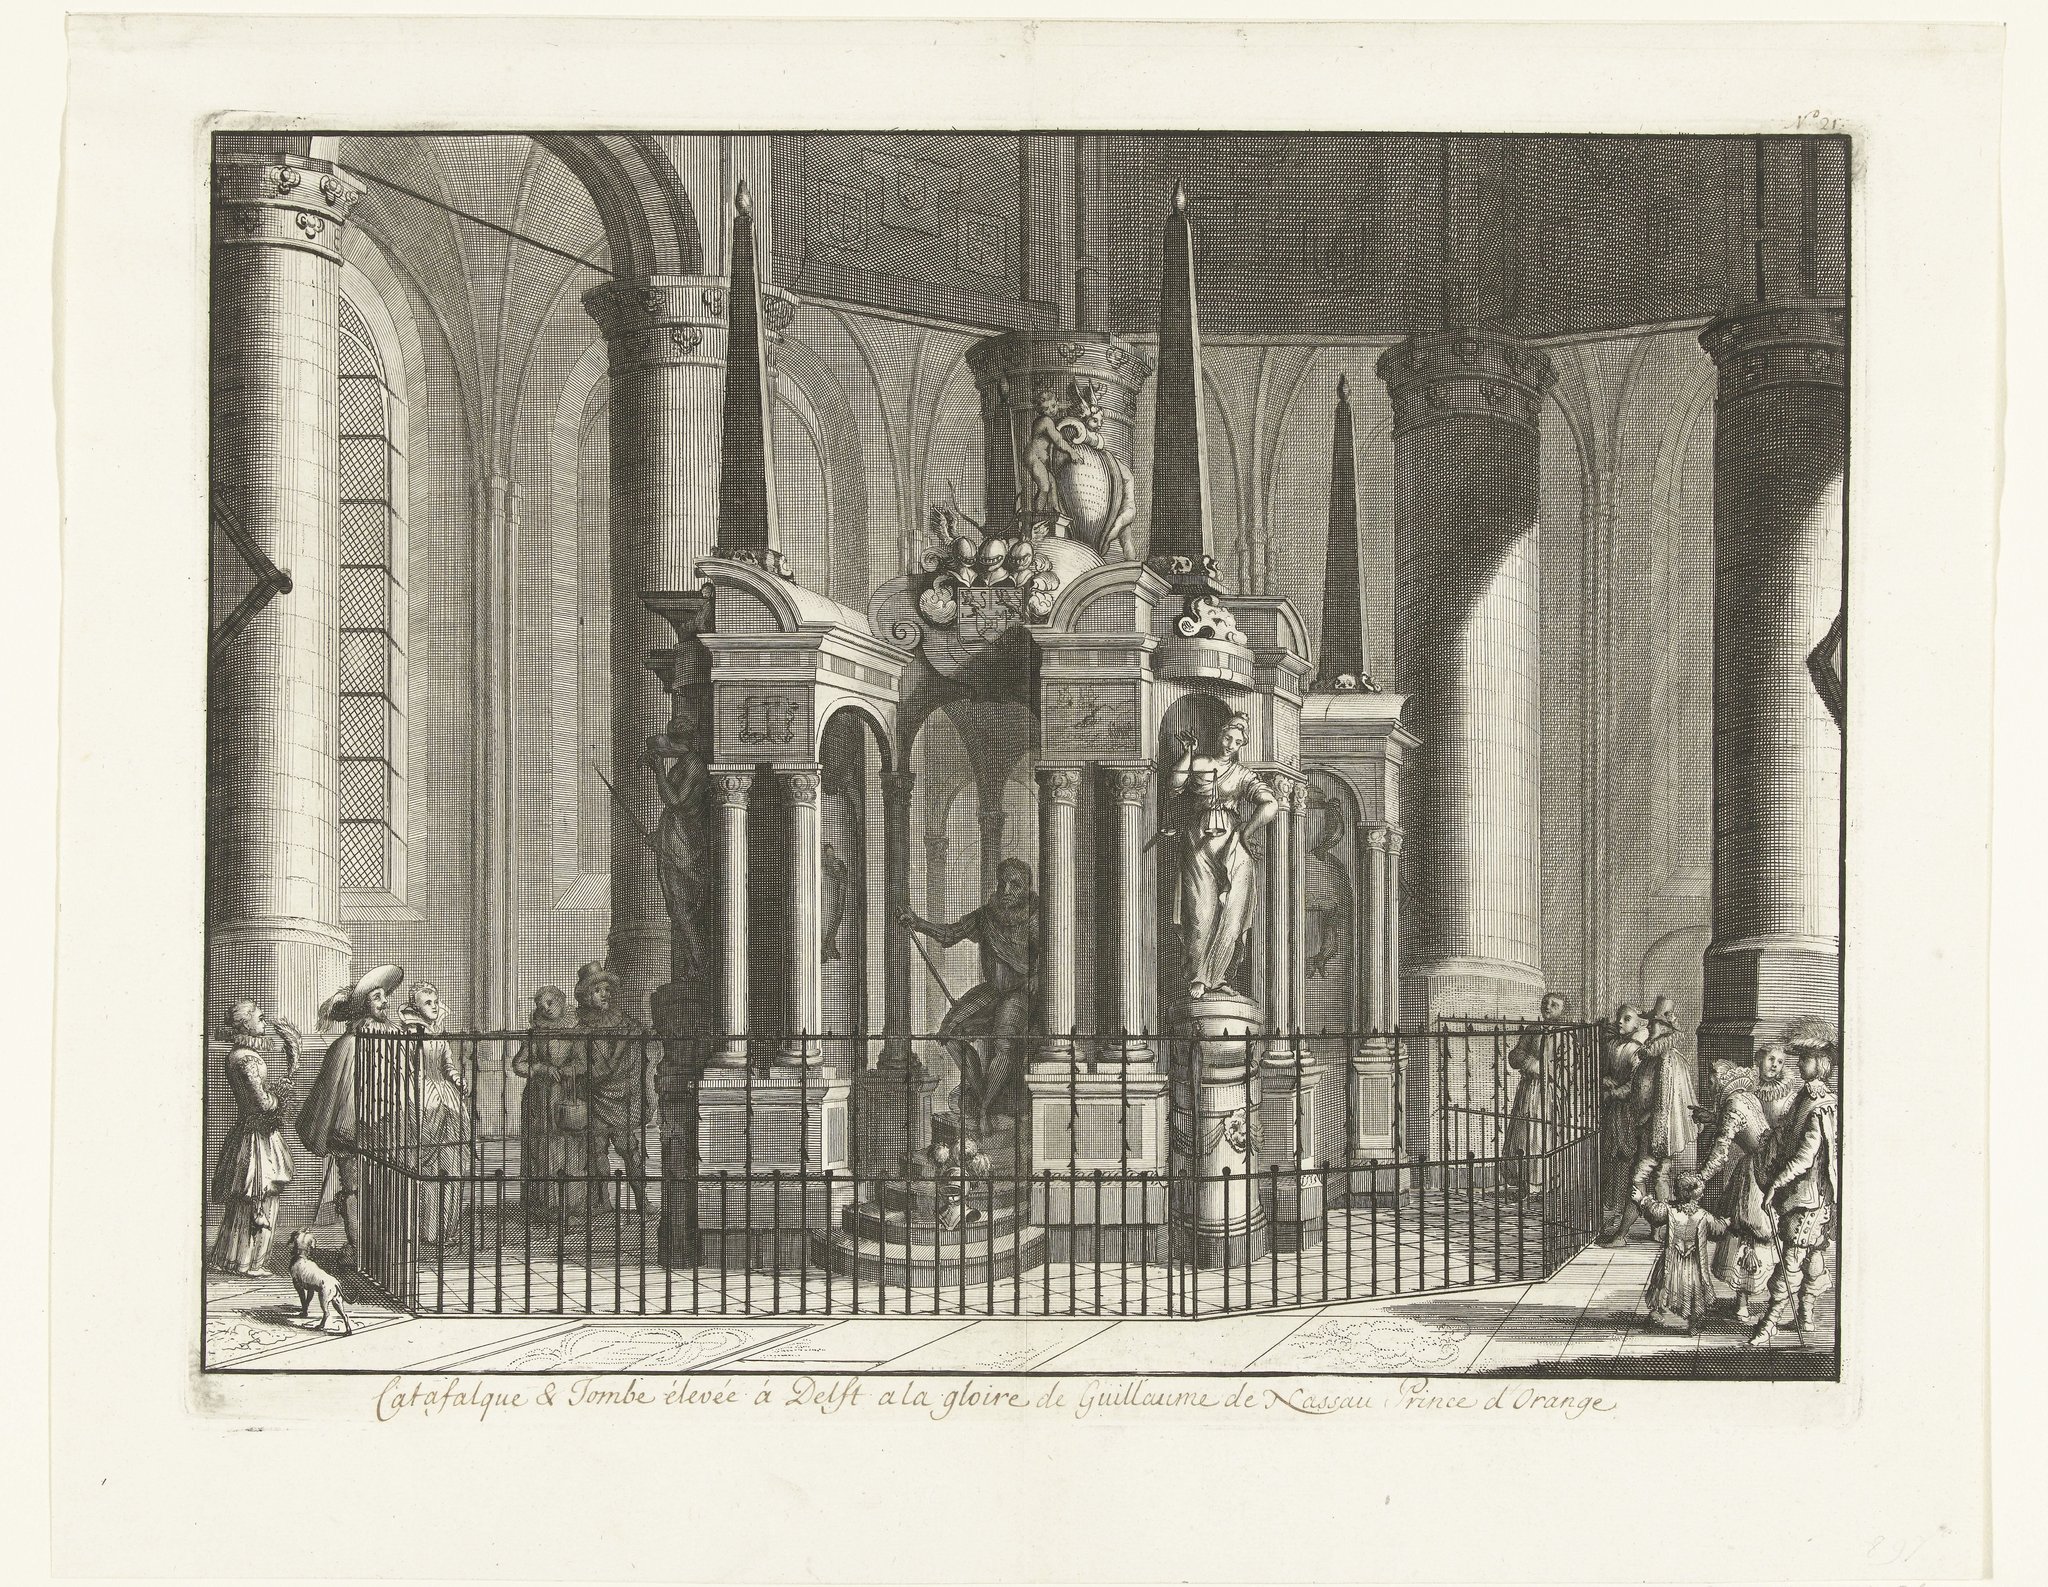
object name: print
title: Graftombe van Willem I, prins van Oranje, 1623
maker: jan luyken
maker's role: draughtsman, print maker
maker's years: 1649-1712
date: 1678-1680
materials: paper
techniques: etching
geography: low countries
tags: delft, william i (prince of orange), grave-building, monumental tomb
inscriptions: inscription: ‘Catafalque & Tombe élevée à Delft a la gloire de Guillaume de Nassau Prince d'Orange / No. 21’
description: De hier vermelde titel verwijst naar de hoogst verkregen titel van de geportretteerde, niet per se naar de titel die de geportretteerde op deze voorstelling draagt. Deze staat ter voorbereiding voor gebruik als illustratie in: J. le Clerc, Geschiedenissen der Vereenigde Nederlanden, sedert den aanvang van die Republyk tot op den Vrede van Utrecht in 't jaar 1713 en het Tractaat van Barriere in 't jaar 1715 gesloten, Z. Chatelain, Amsterdam 1730, 3 delen. Staat vóór de letter.